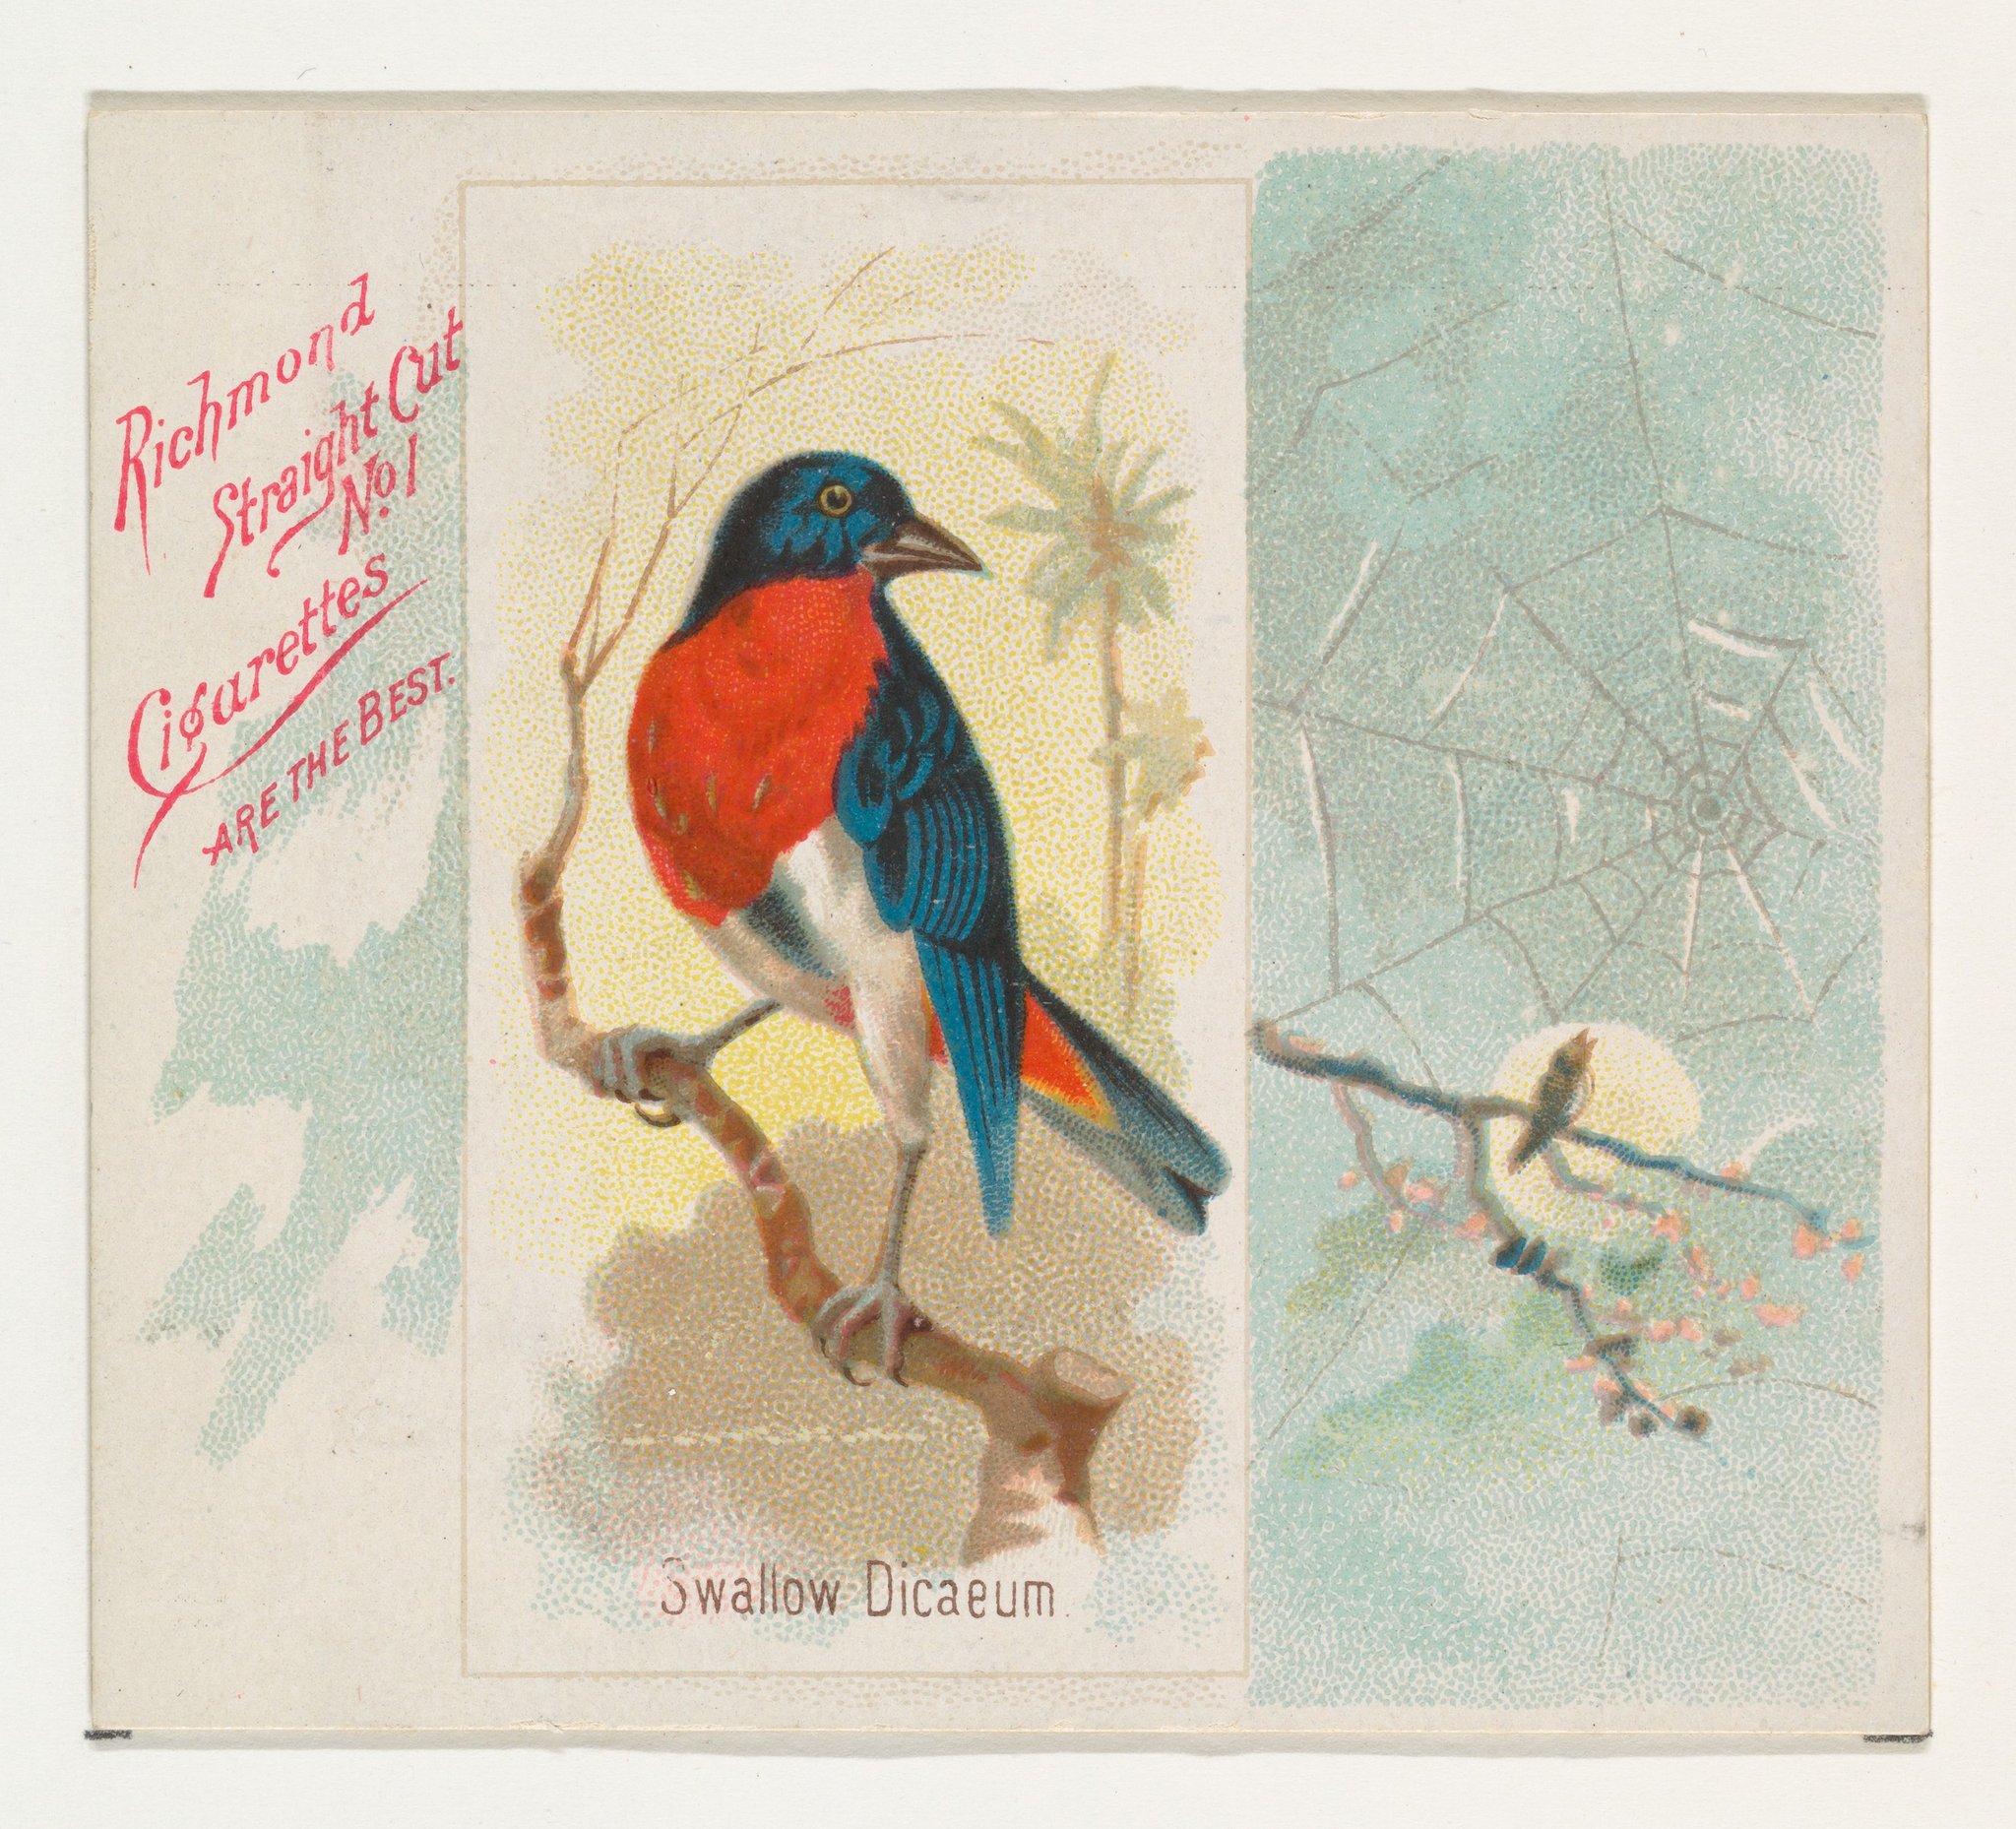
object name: print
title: Swallow Dicaeum, from the Song Birds of the World series (N42) for Allen & Ginter Cigarettes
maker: allen & ginter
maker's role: publisher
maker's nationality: american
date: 1890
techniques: color lithograph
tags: birds